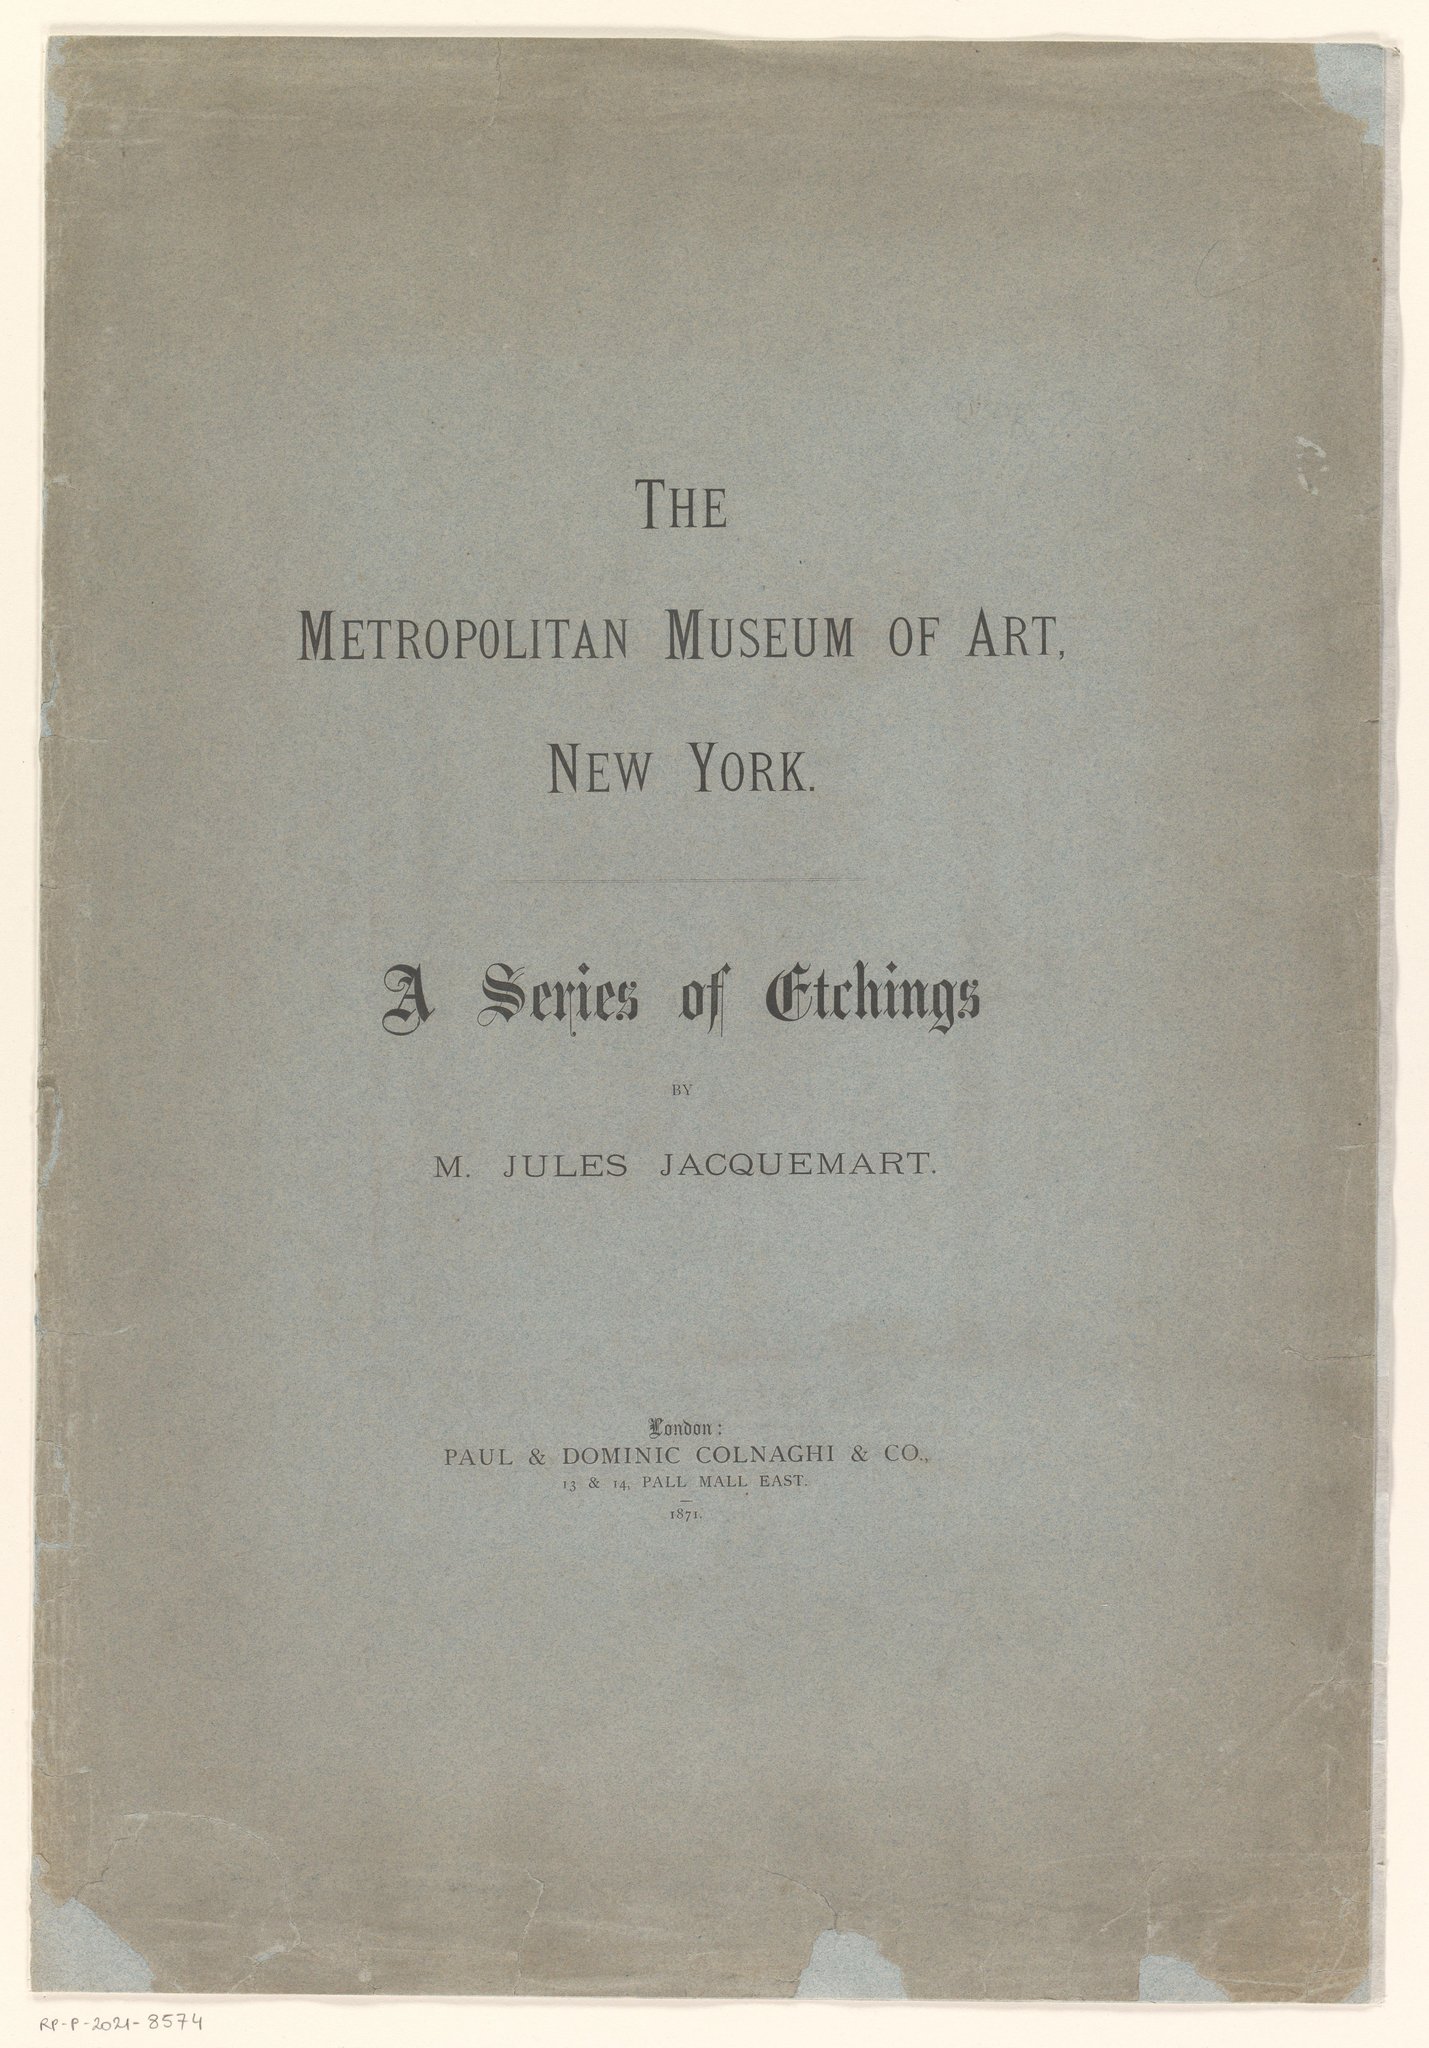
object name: wrapper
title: Omslag voor elf prenten van Jules Jacquemart naar schilderijen in The Metropolitan Museum of Art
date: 1871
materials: paper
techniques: letterpress printing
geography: london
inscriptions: inscription: ‘Overgedragen aan het Rijksprentenkabinet jan. 1985’